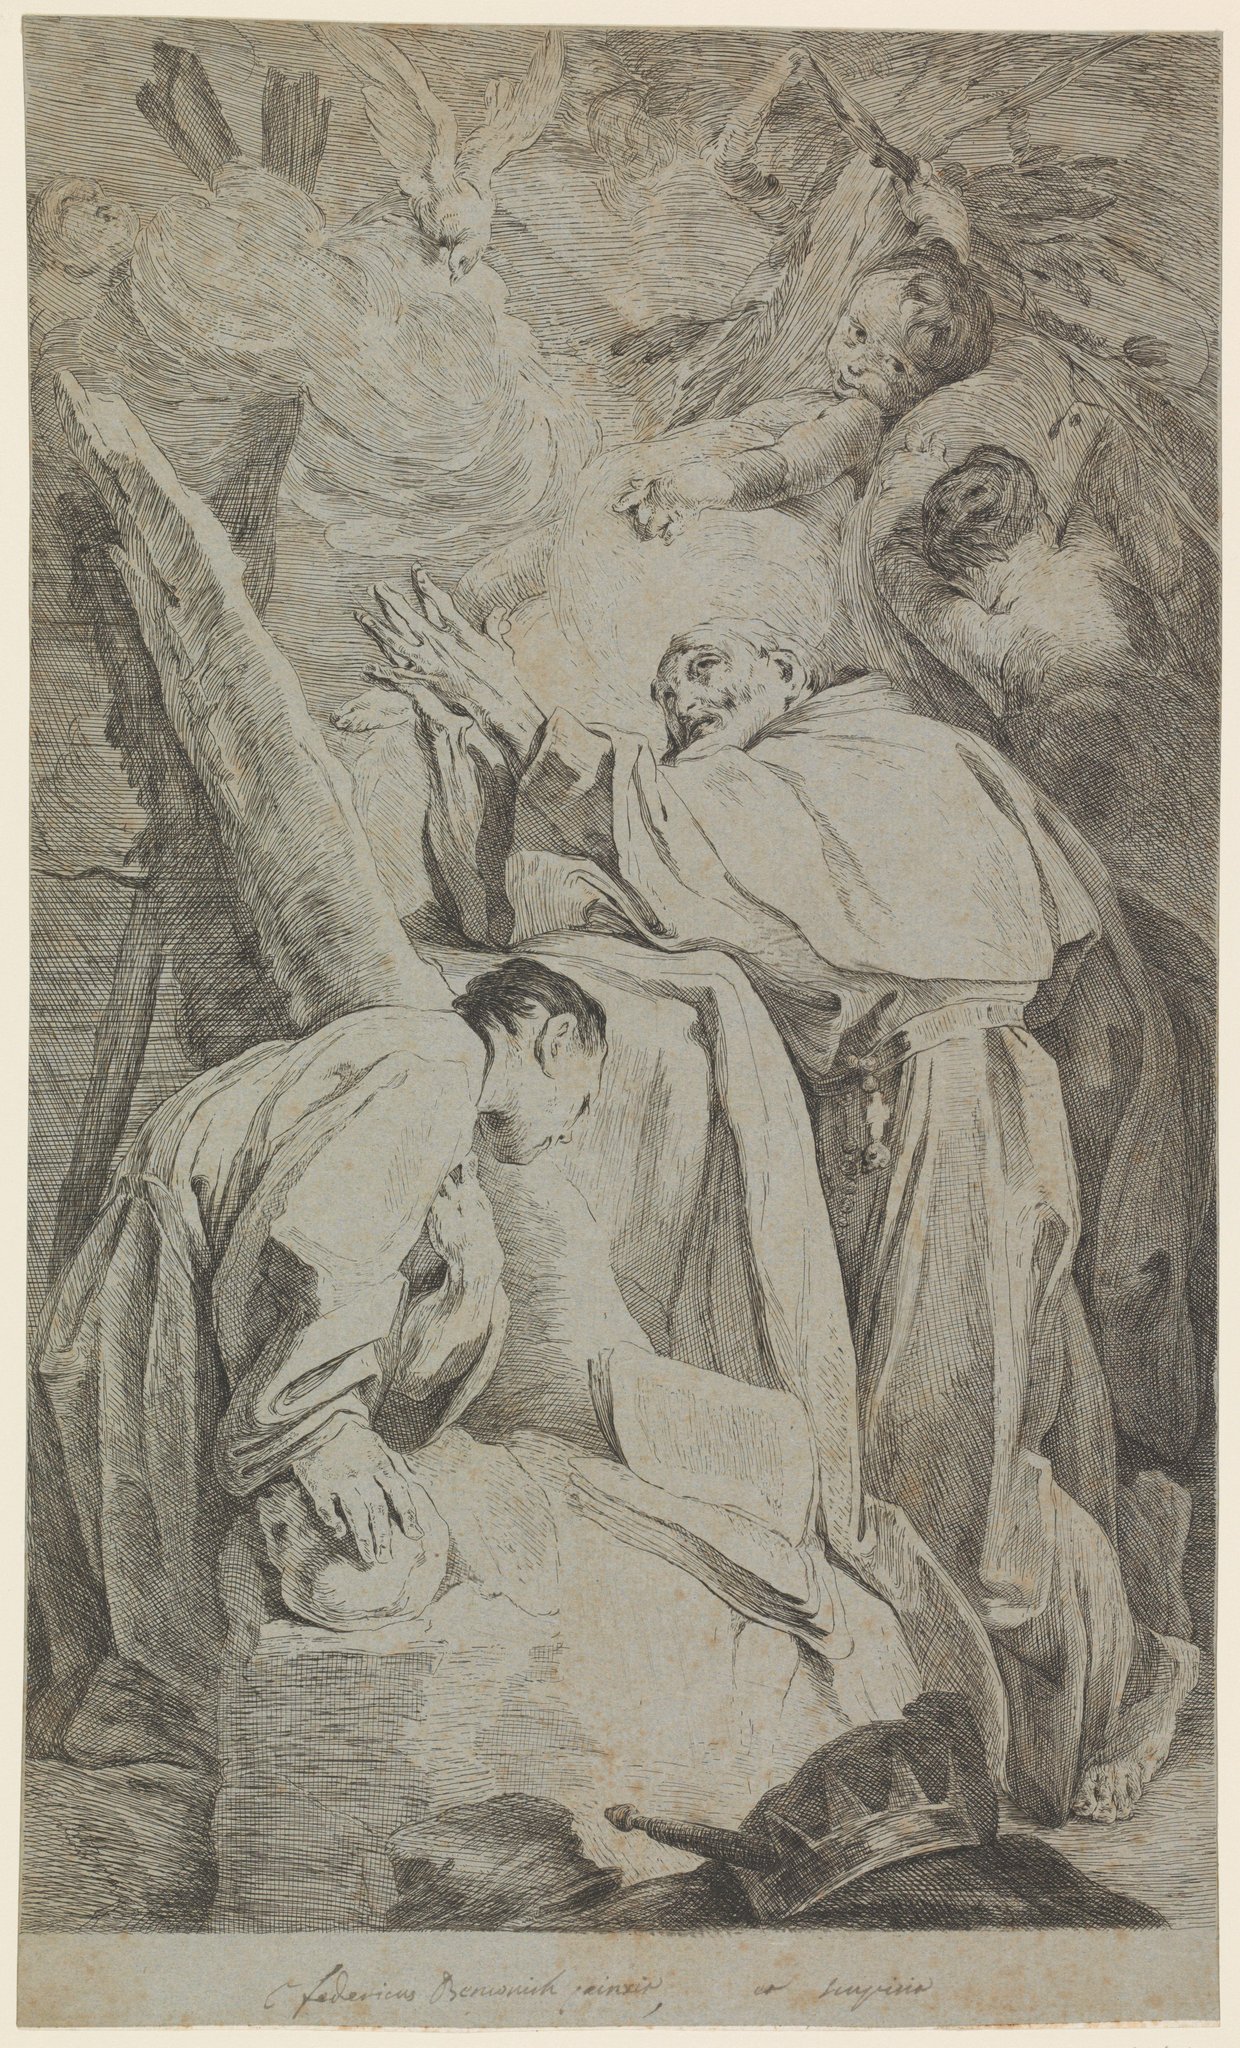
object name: print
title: Pietro Gambacorti van Pisa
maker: federico bencovich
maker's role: print maker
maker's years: 1677-1753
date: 1806-1830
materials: paper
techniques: etching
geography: italy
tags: saints, monk(s), friar(s), cupids: 'amores', 'amoretti', 'putti'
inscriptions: inscription: ‘Federicus Benovich pinxit [...]’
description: Pietro Gambacorti van Pisa geknield in gebed voor een crucifix. Links een lezende jonge monnik die met zijn hand rust op een schedel. Op de voorgrond een kroon. Boven twee putti en een duif.